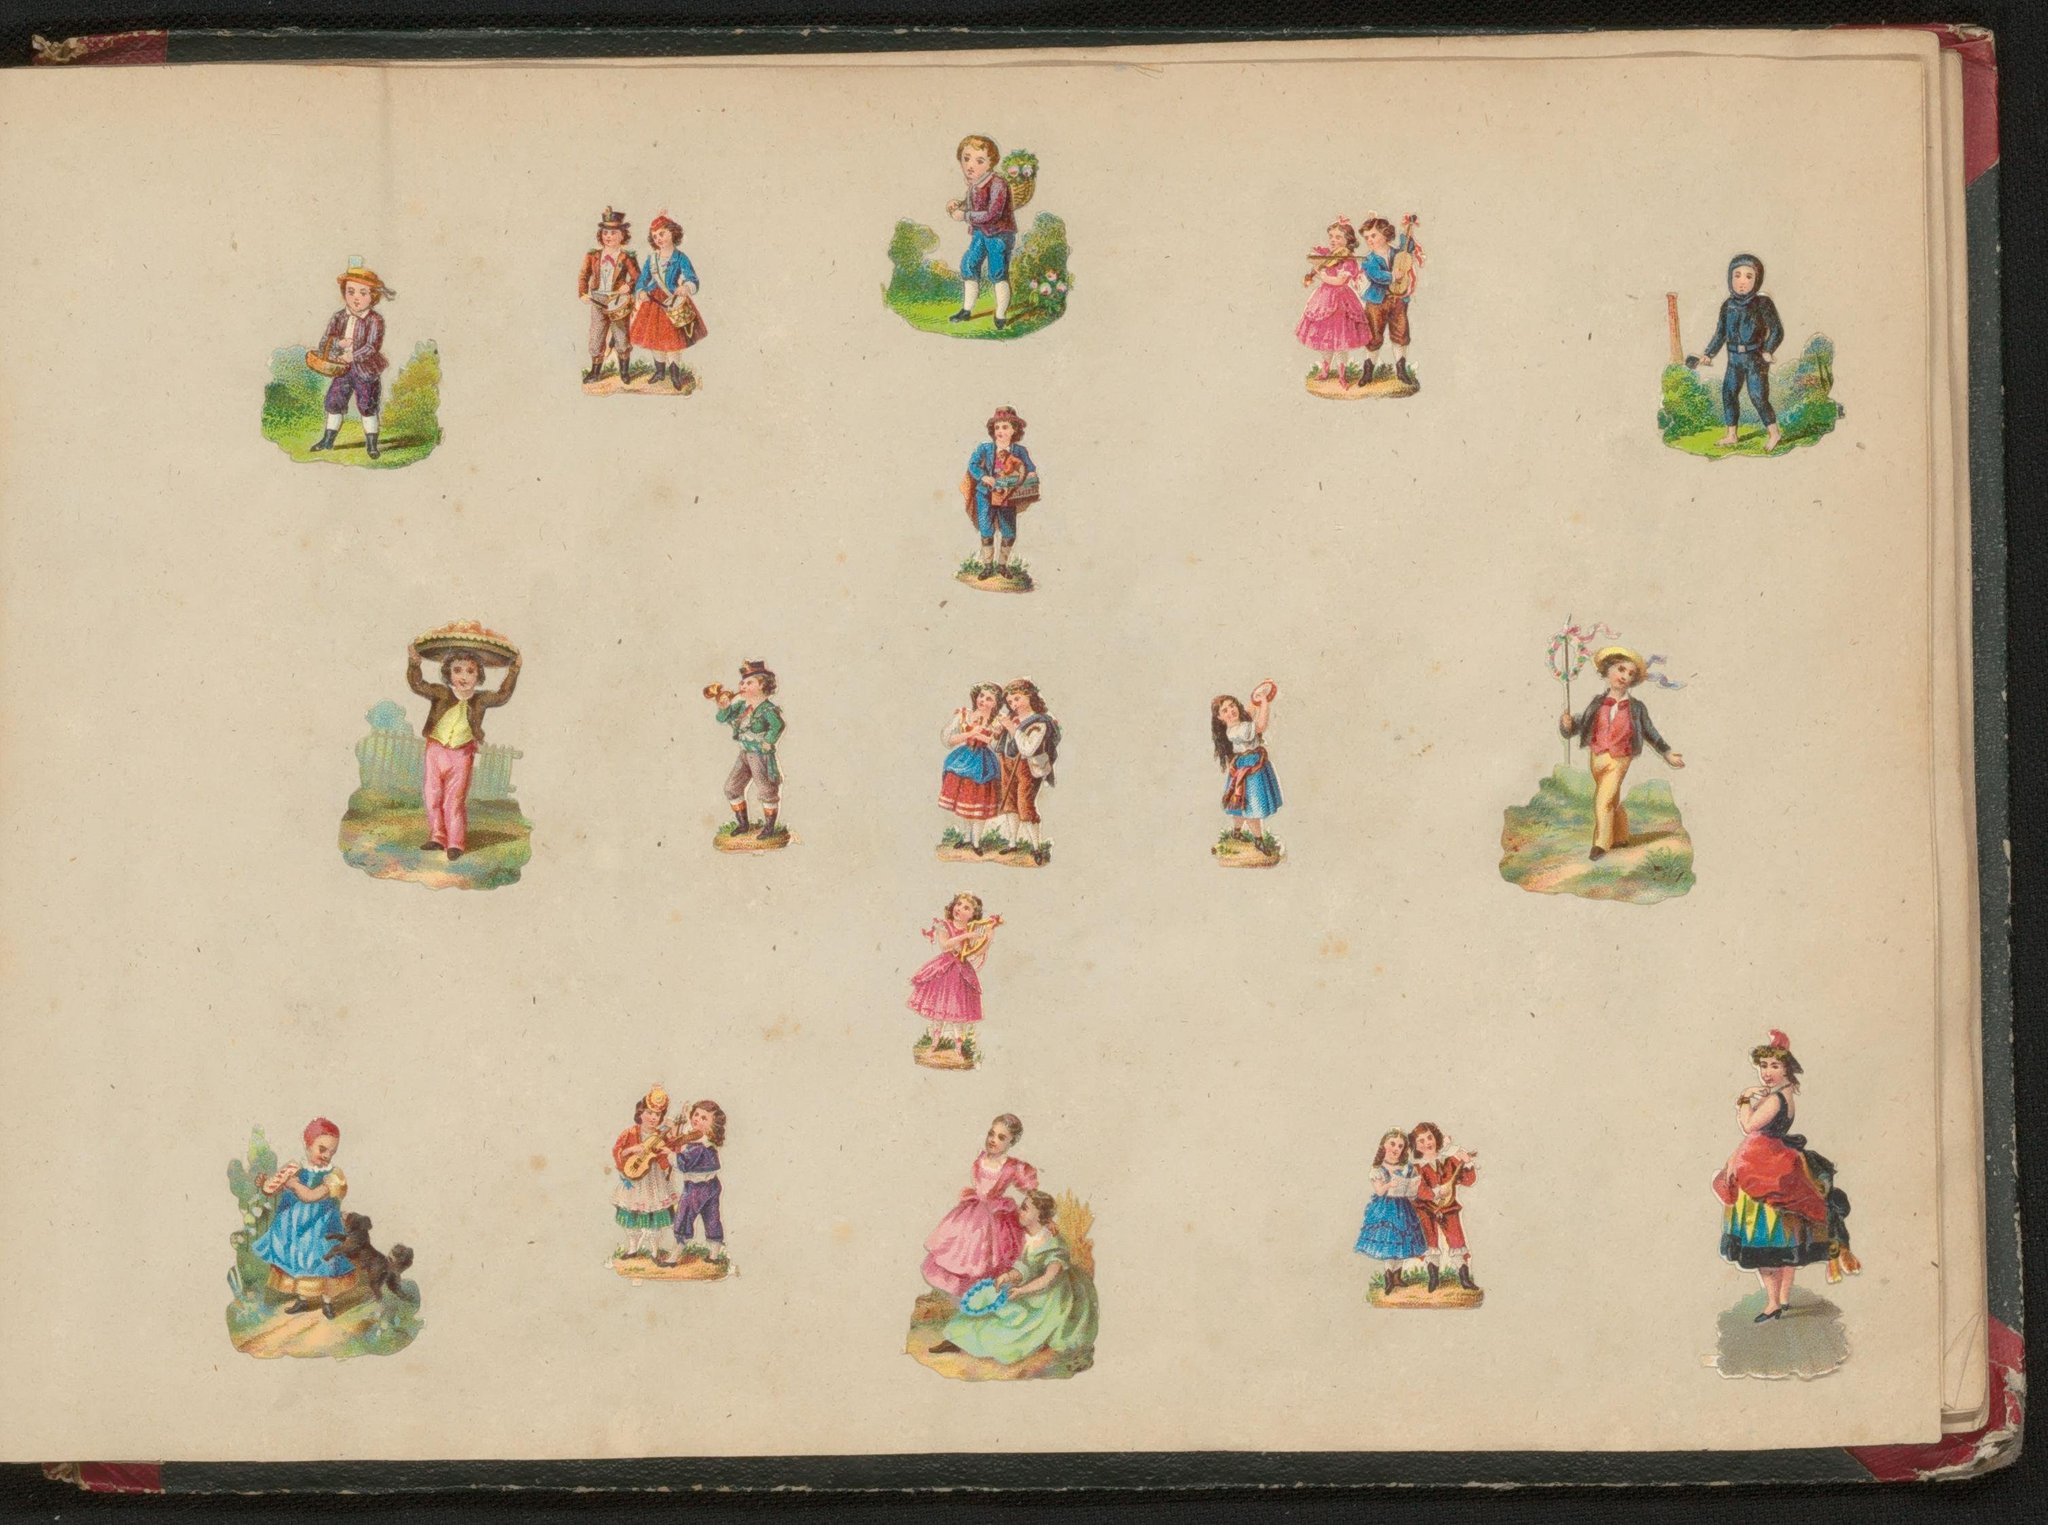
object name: album leaf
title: Albumblad met 17 plakplaatjes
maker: Anonymous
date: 1880-1910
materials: paper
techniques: chromolithography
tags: children's games and plays, making music; musician with instrument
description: Albumblad met 17 plakplaatjes van kinderen die muziek maken. Onderdeel van het plakboek met 38 bladen gevuld met plakplaatjes, poesieplaatjes en uitgeknipte en ingeplakte fragmenten van prenten. Onderwerpsrubrieken binnen de Atlas Zeden en Gewoonten: Schoone kunsten, Varia.